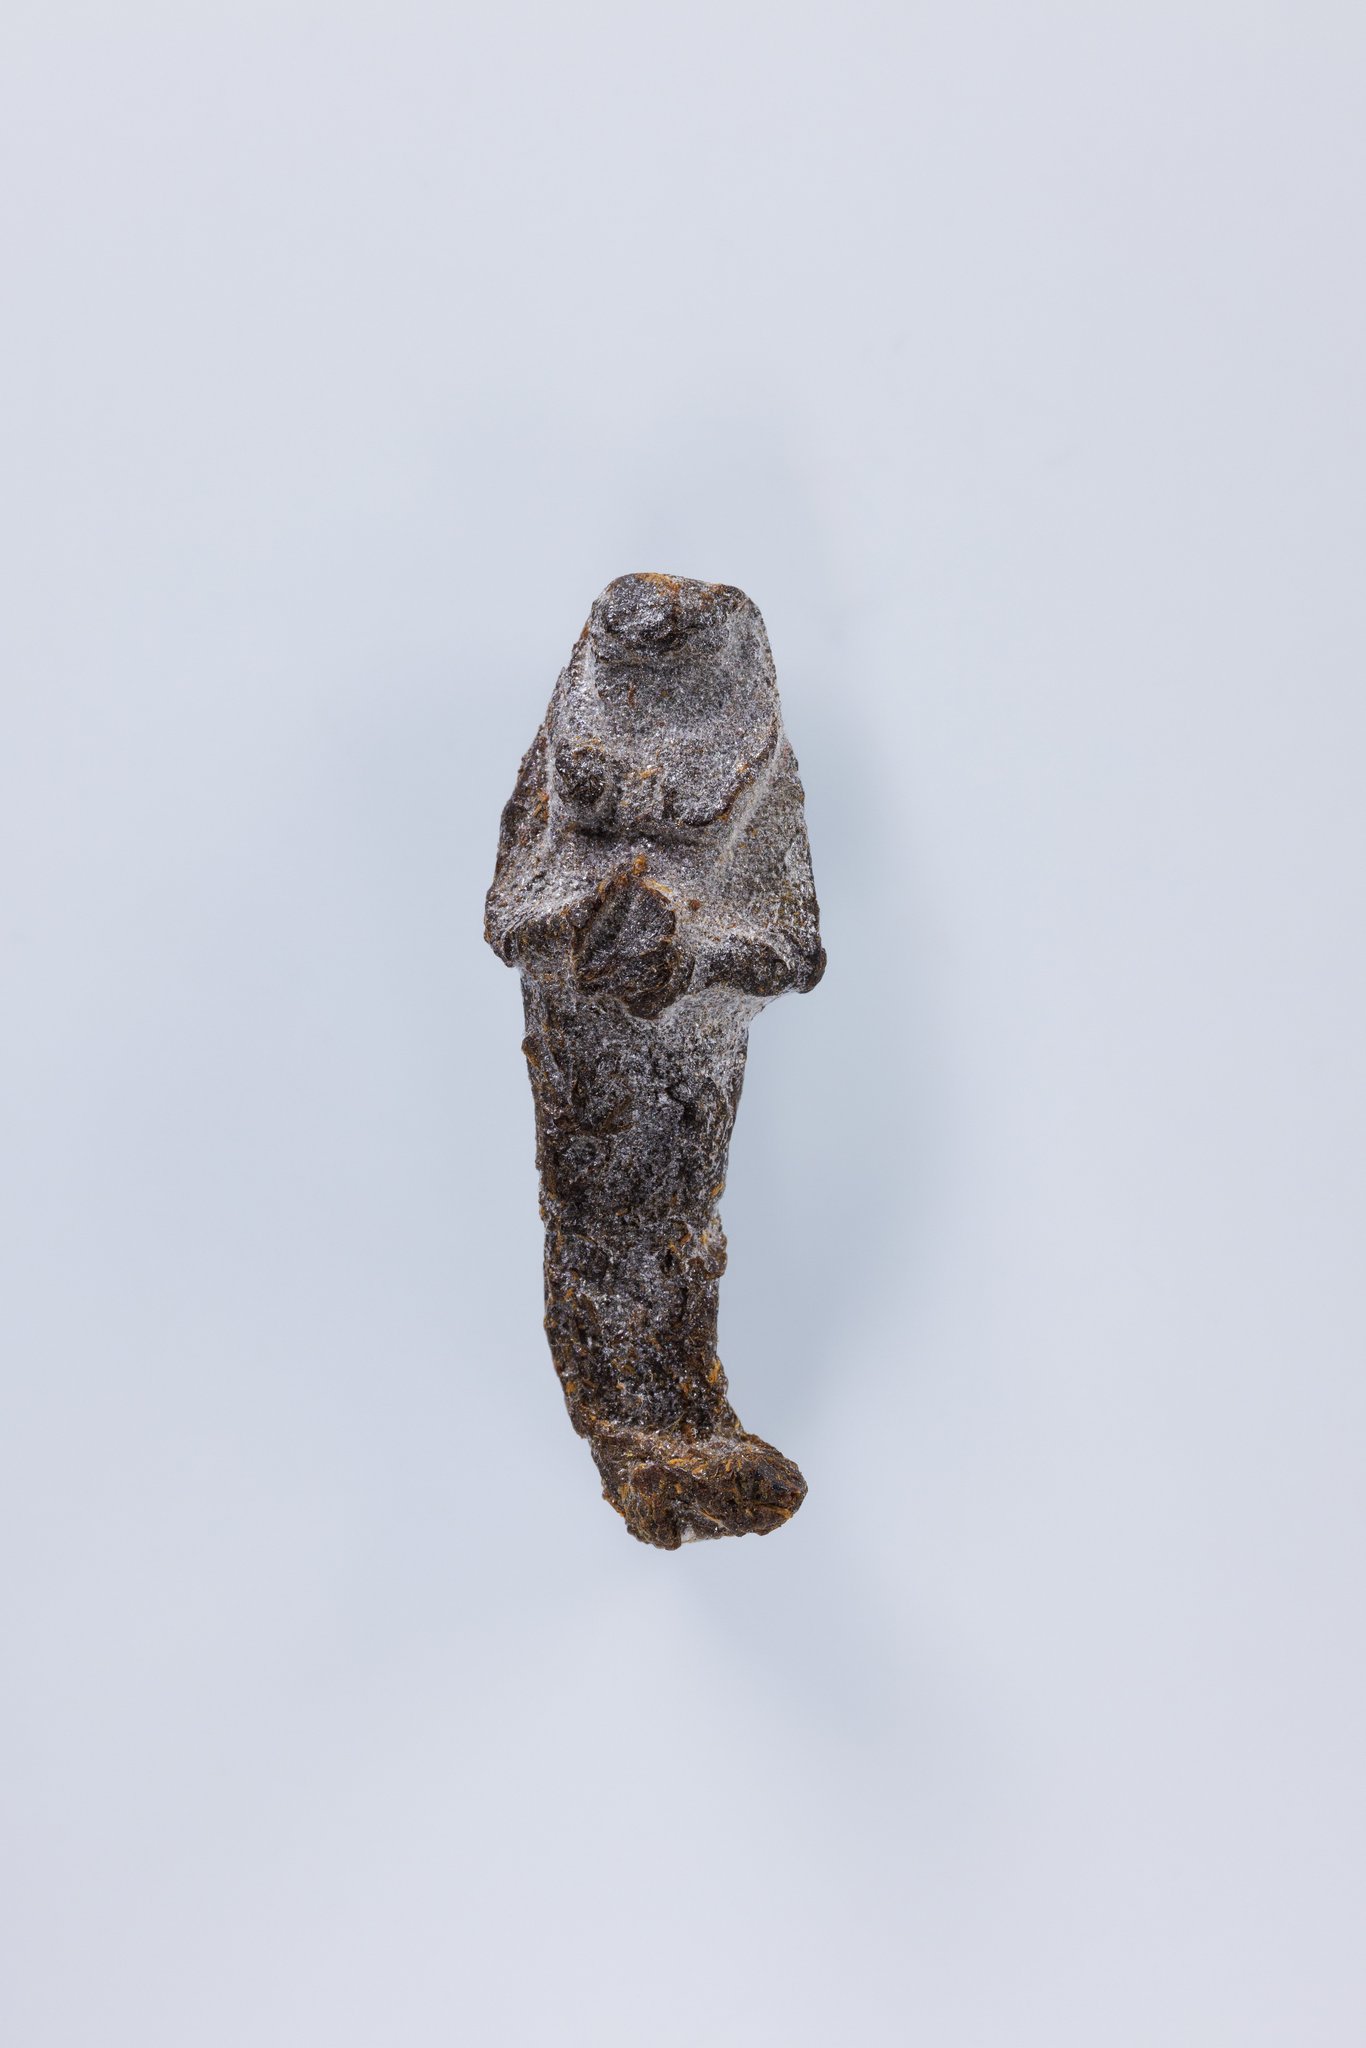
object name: four son of horus, qebehsenuef, falcon headed, djedmutesankh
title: Viscera figure with falcon head (Qebehsenuef)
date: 1000-945 BCE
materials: wax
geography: egypt